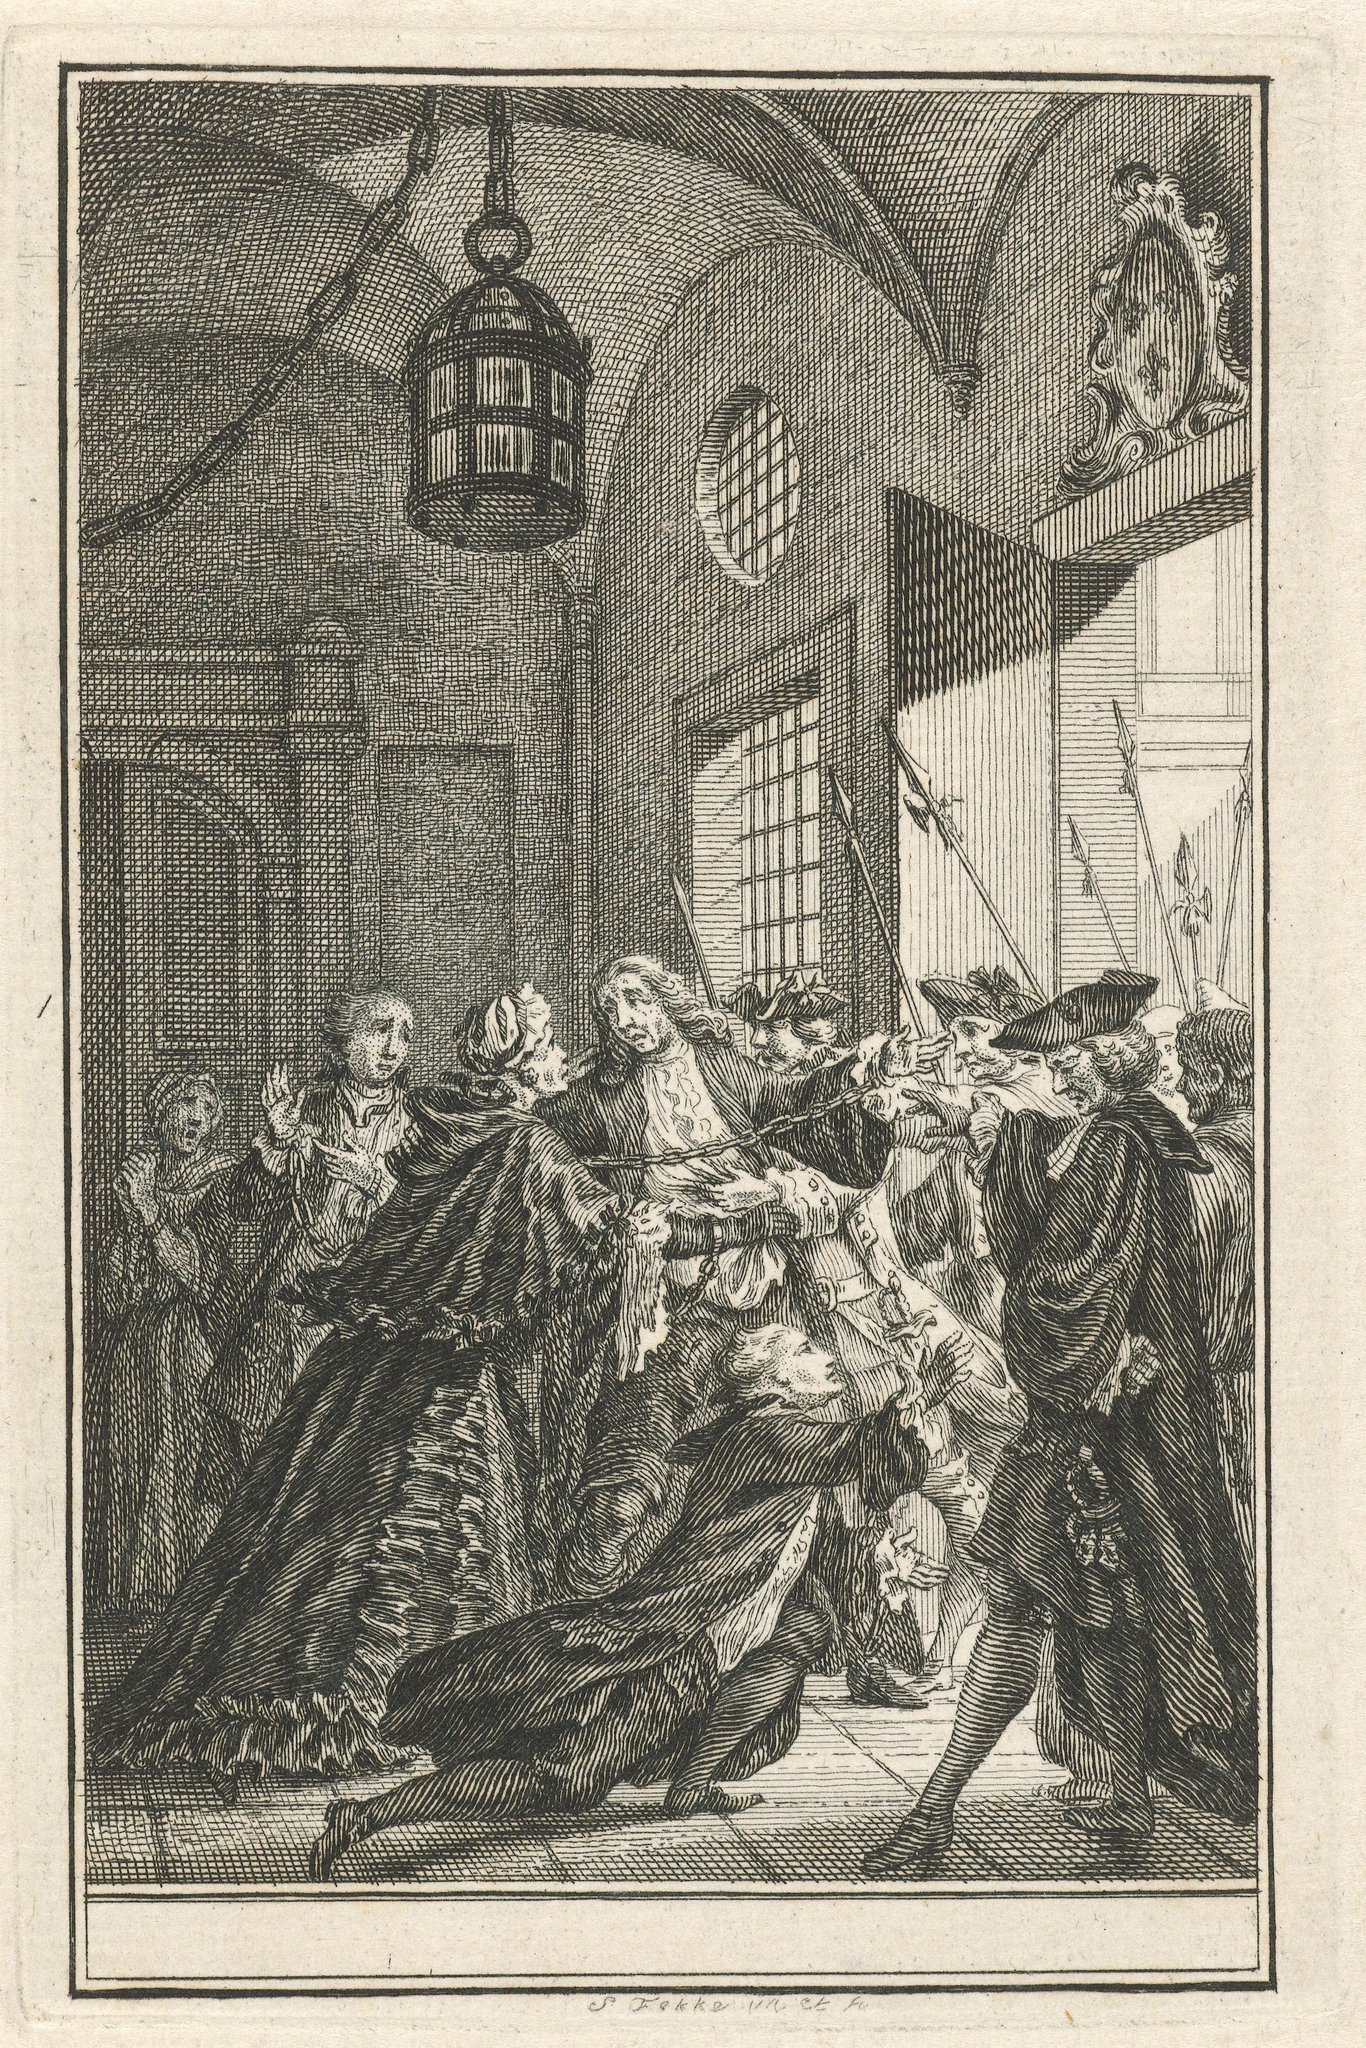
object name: print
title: Vier gevangenen onder toezicht van schutters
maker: simon fokke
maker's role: draughtsman, print maker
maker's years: 1712-1784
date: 1722-1784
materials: paper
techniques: etching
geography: amsterdam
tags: prisoner with hands bound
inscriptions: collector's mark: Lugt 240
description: Vier geboeide gevangenen staan onder toezicht van bewakers in een hal. Een mannelijke gevangene wordt door een bewaker tegengehouden wanneer hij een eveneens geboeide vrouw wil omarmen. Op de voorgrond knielt een gevangene voor de opzichter.